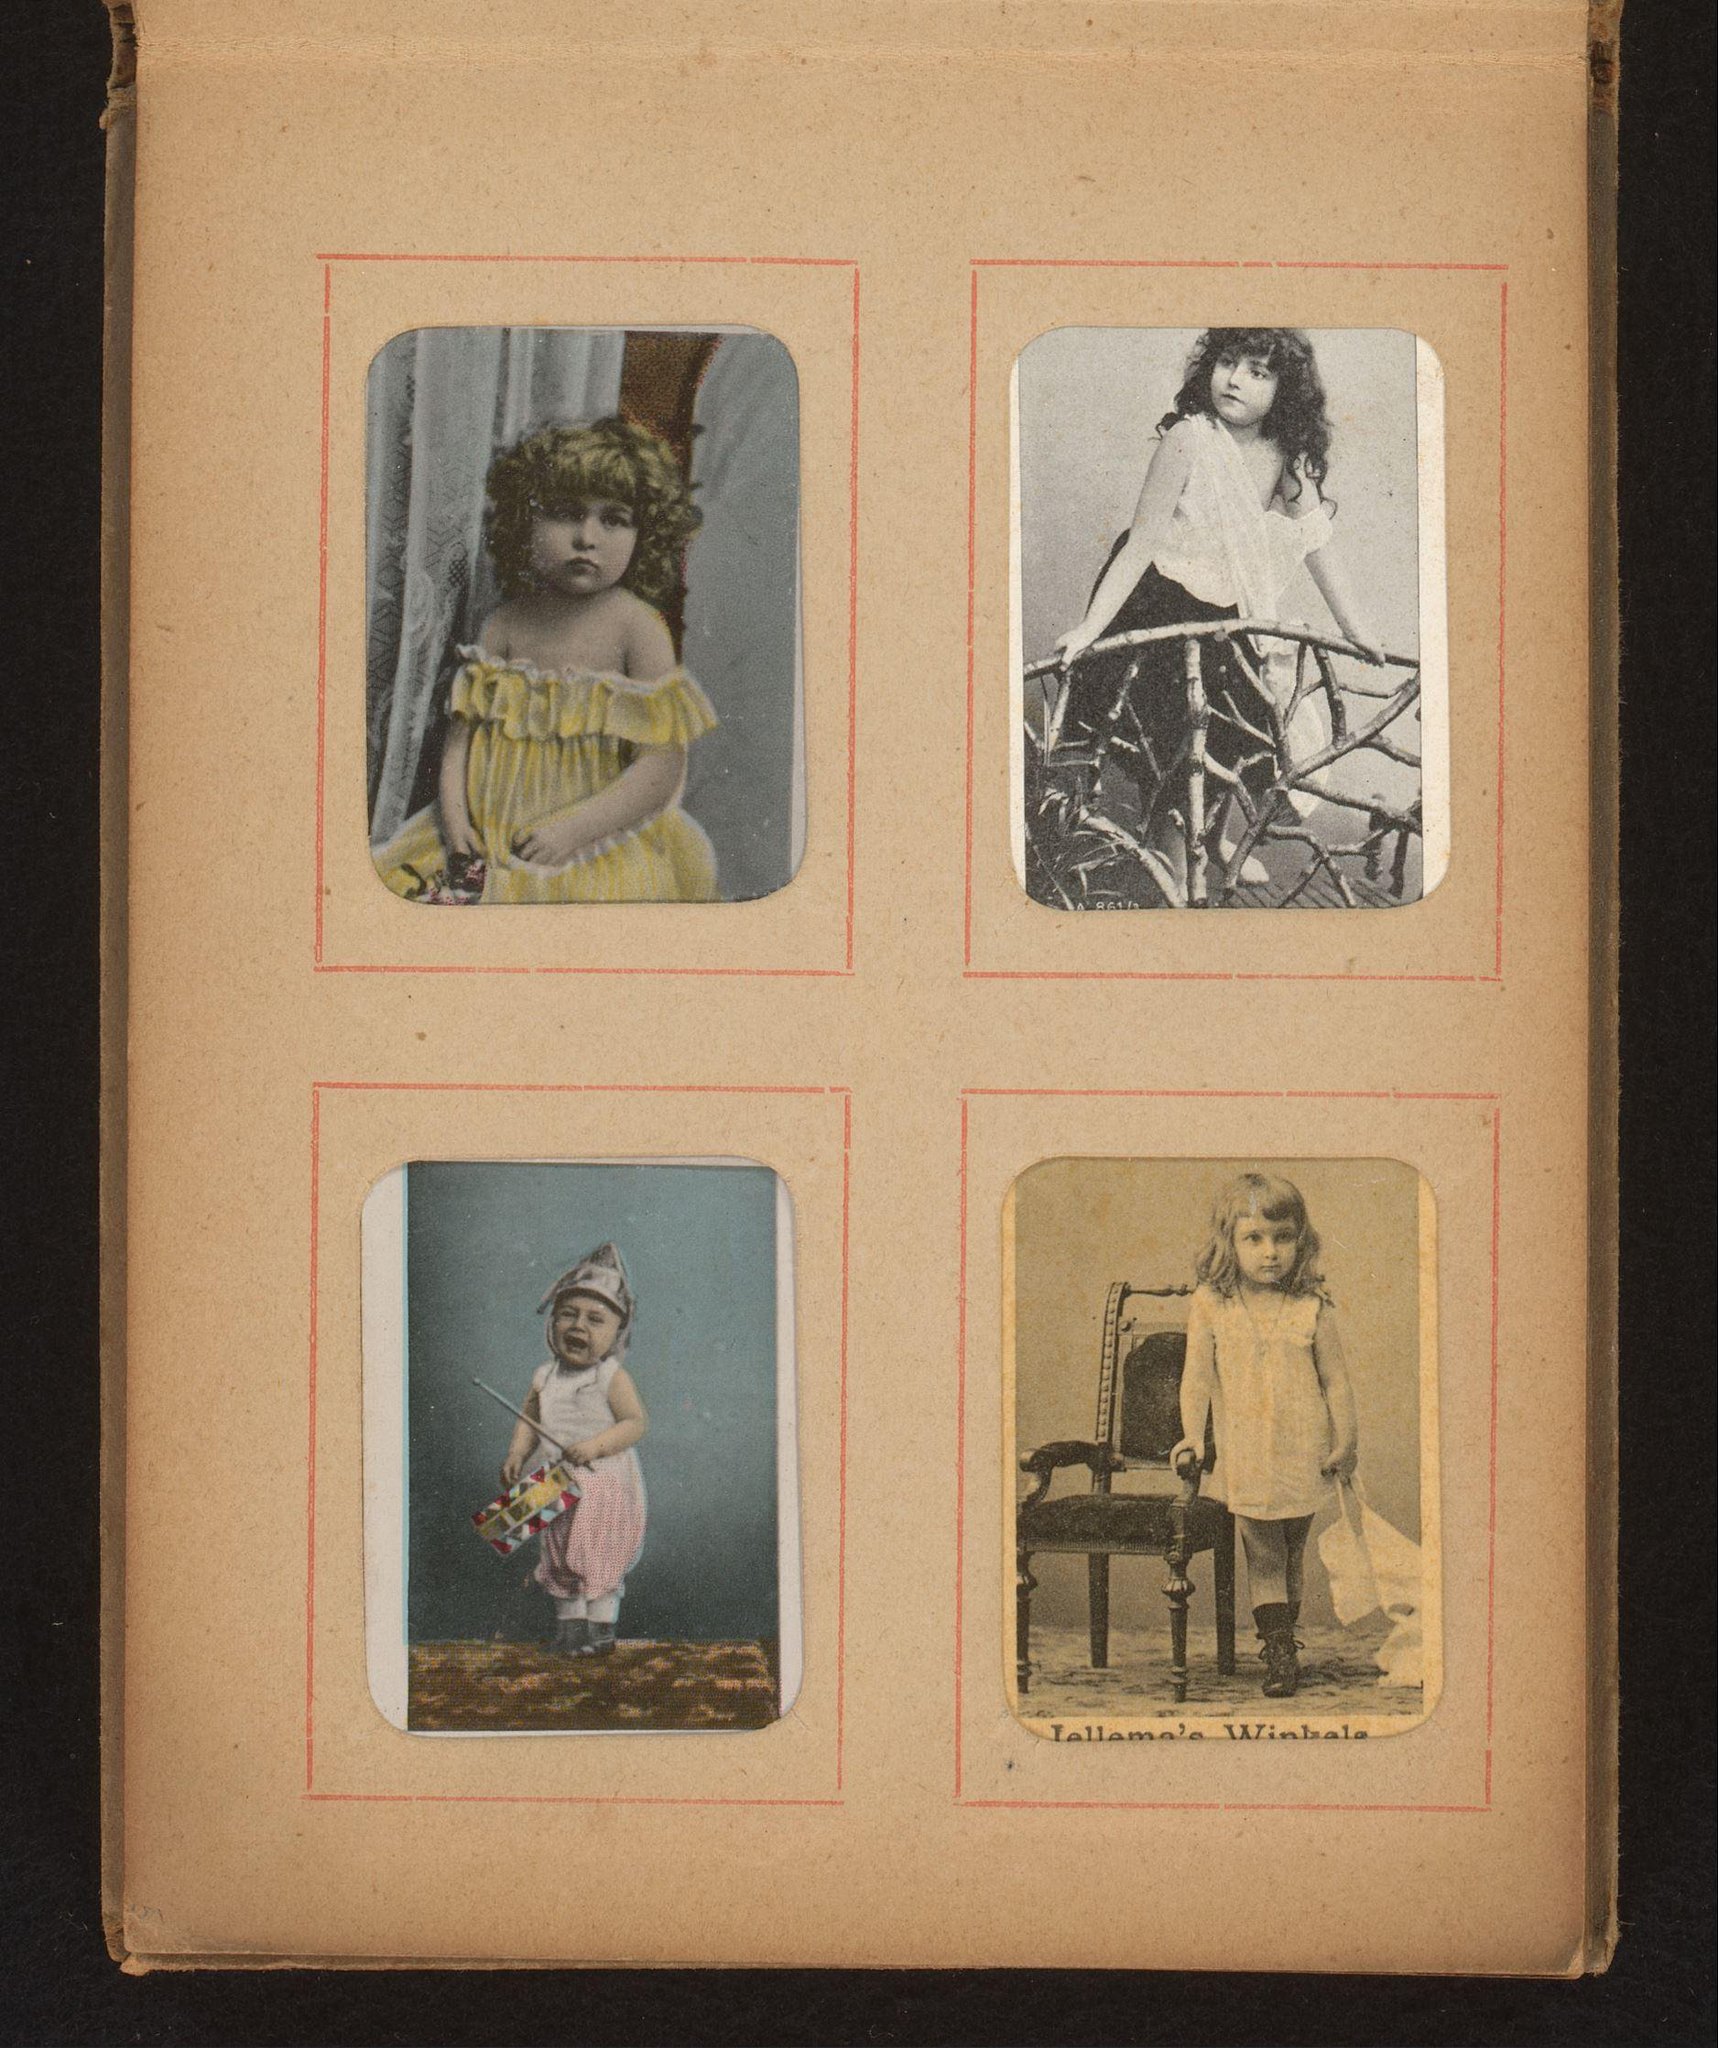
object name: photomechanical print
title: Kinderportretten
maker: Anonymous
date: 1880-1920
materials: paper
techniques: photograph, lithograph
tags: child, drum (musical instrument), crying, shouting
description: Vier portretten van kinderen, waaronder een met het opschrift Jellema's Winkels. Deze pagina maakt deel uit van een album.